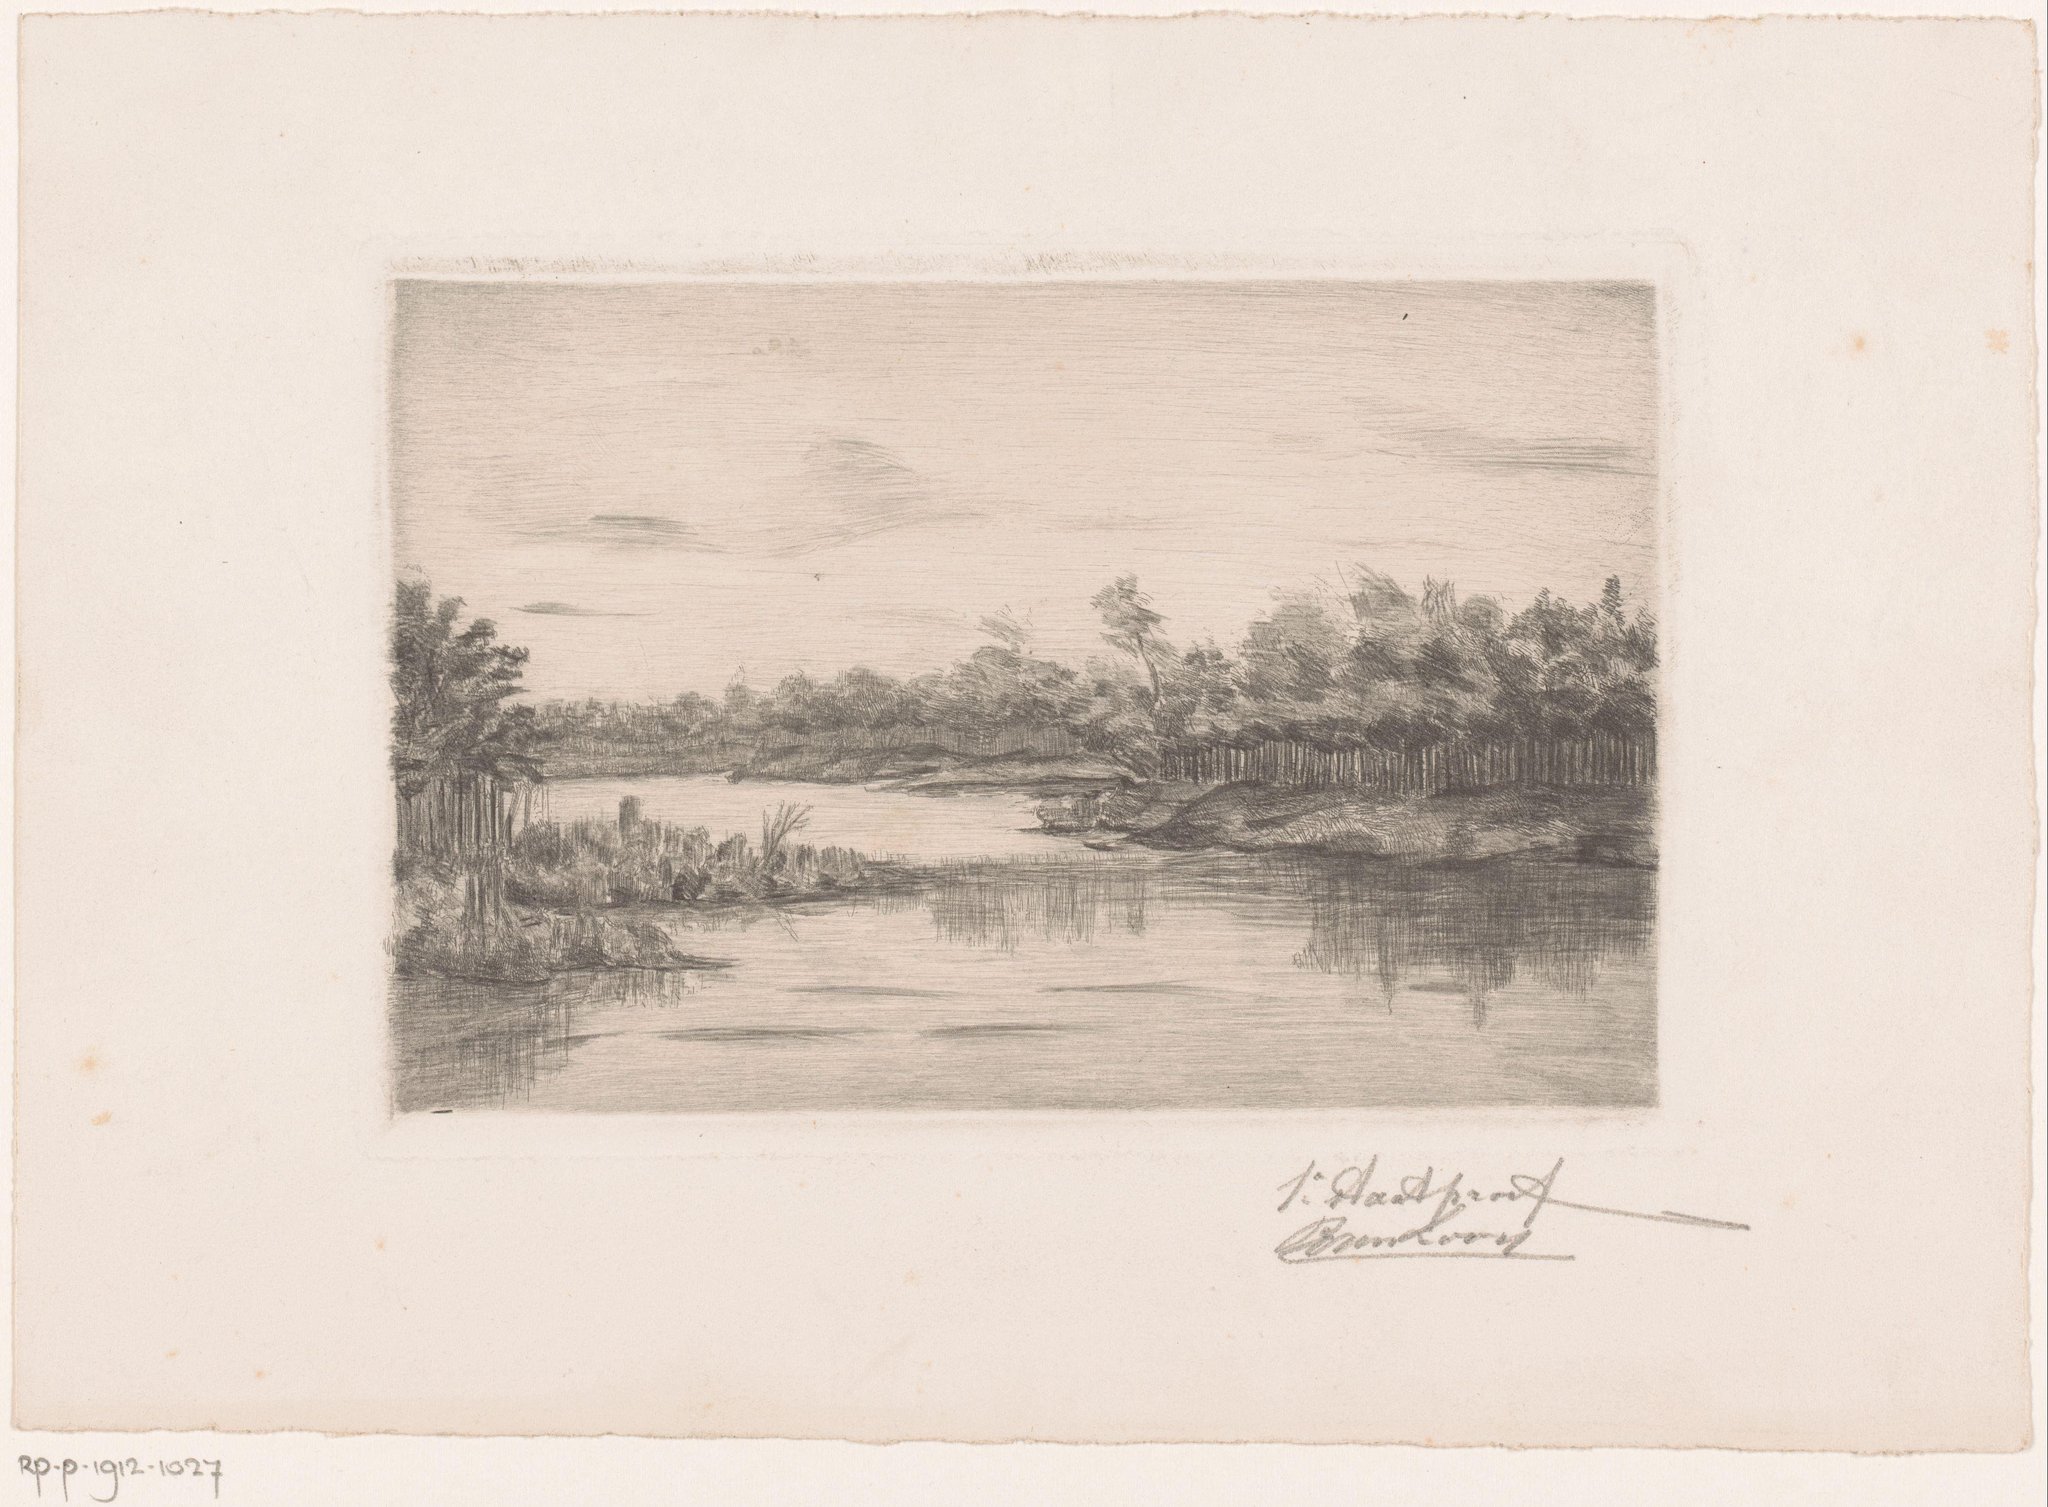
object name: print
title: Boslandschap met een meer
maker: joseph edouard van looy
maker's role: print maker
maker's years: 1871-1896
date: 1881-1912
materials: paper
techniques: etching, intaglio, roulette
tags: lake, forest, wood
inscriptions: annotation: ‘1e staat proef’, collector's mark: Lugt 2228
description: Sterfdatum van de prentmaker is onbekend. Daarom is voor de bepaling van de rechten van dit object gebruik gemaakt van de verwervingsdatum Rijksmuseum Amsterdam.